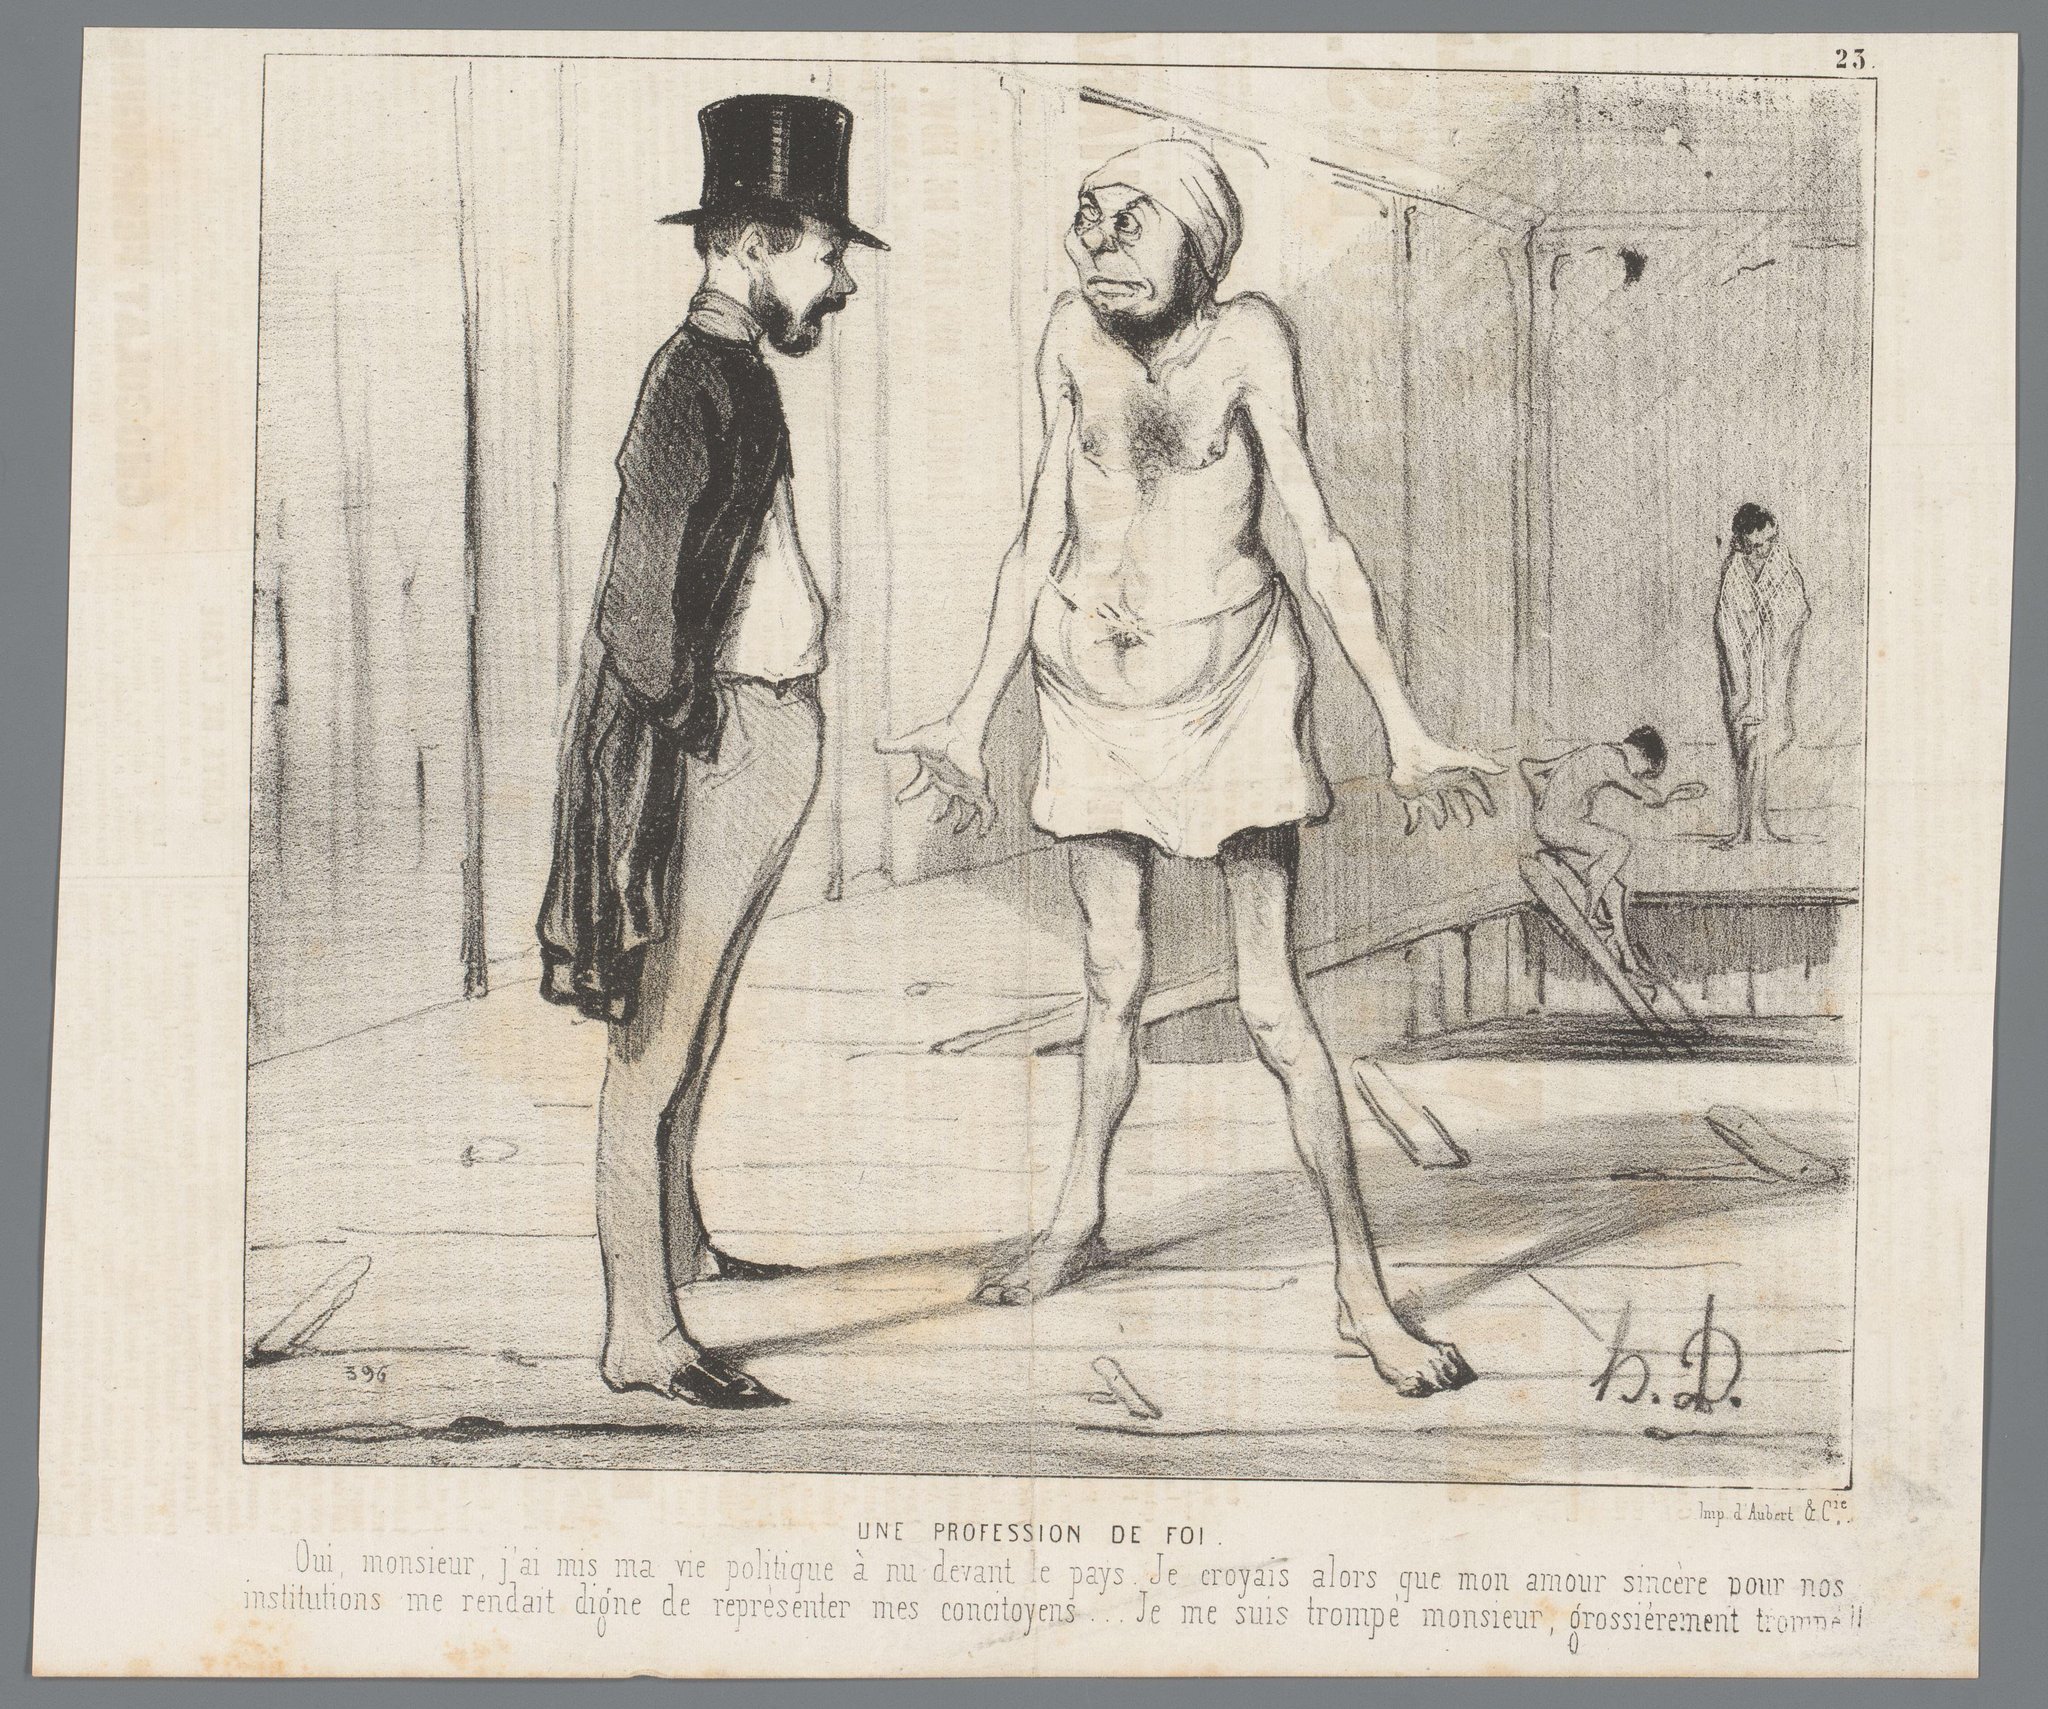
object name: cartoon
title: Les baigneurs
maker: honoré daumier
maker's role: draughtsman, painter, print maker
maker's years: 1808-1879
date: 1842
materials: paper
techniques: letterpress printing, lithograph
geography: paris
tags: taking a bath, caricatures (human types), man (showing himself) undressed, quasi-nude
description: Prent uit: Le Charivari, 23 september 1842.